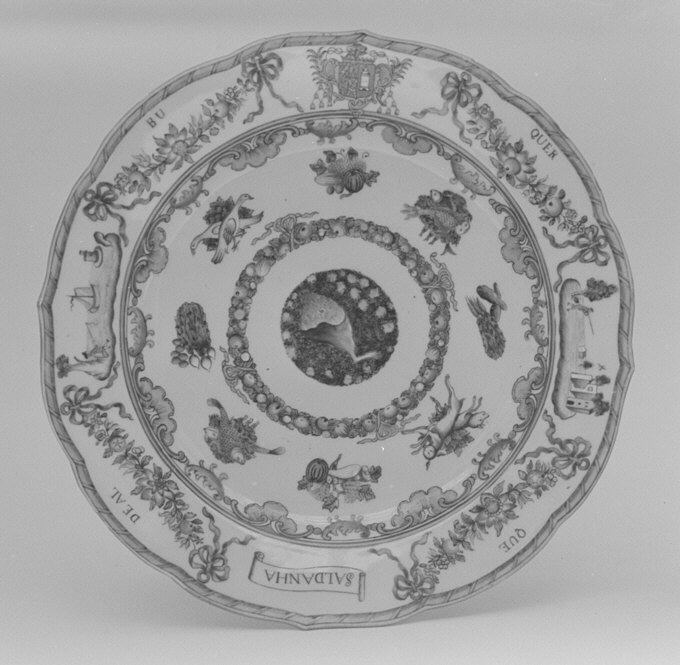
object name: plate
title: Plate (part of a service)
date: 1765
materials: hard paste porcelain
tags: animals,flowers,coat of arms